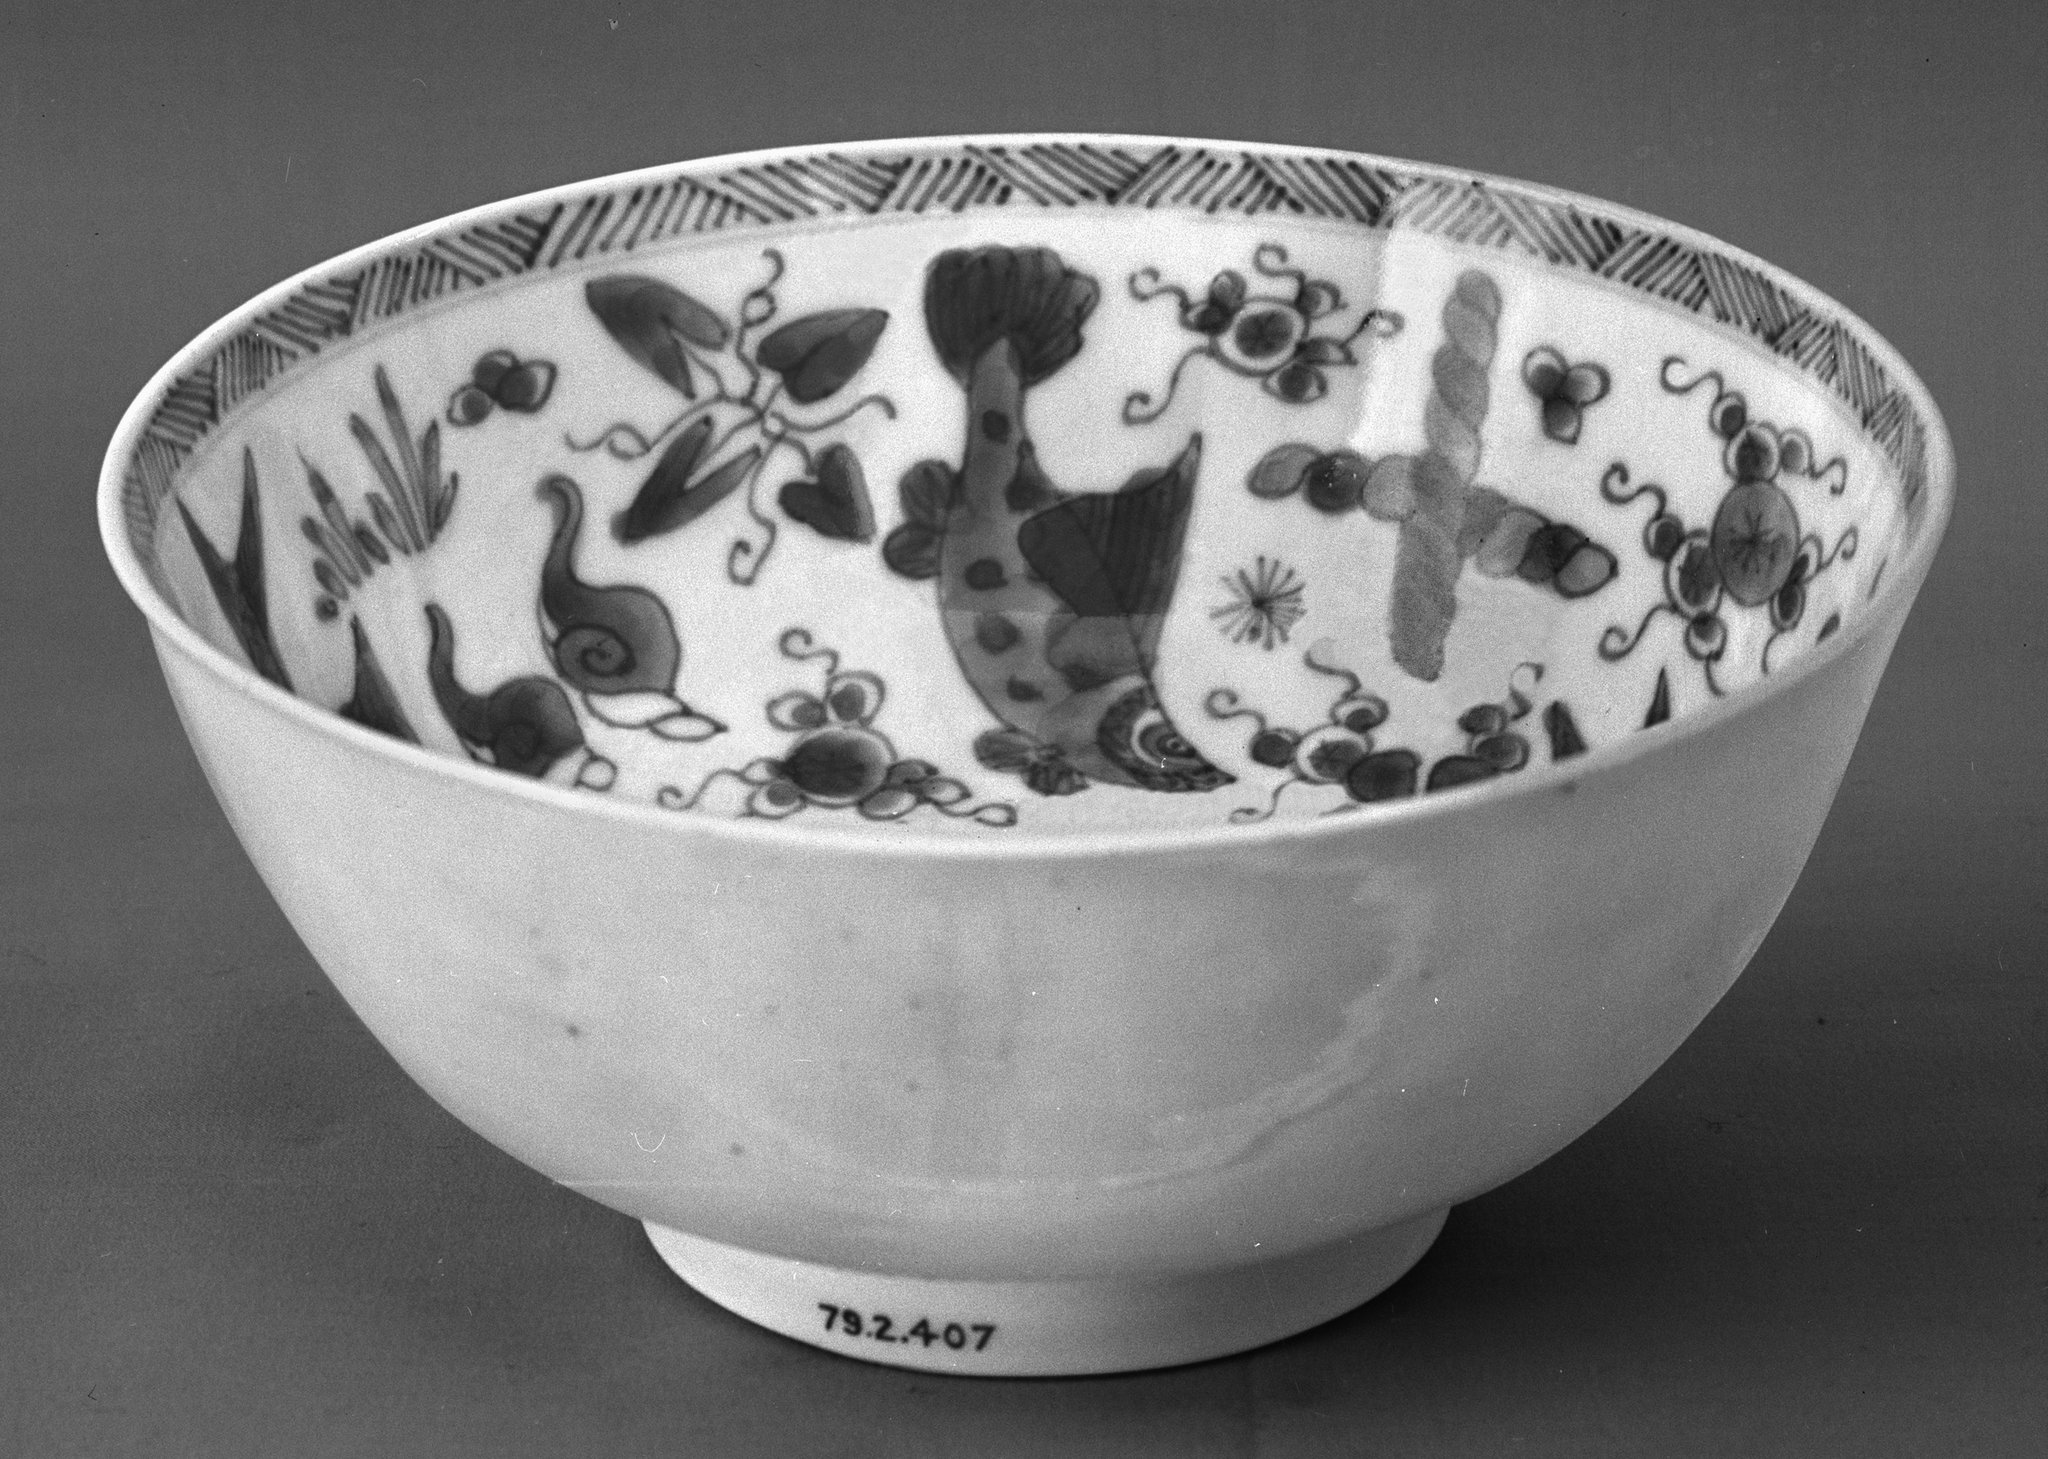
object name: bowl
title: Bowl with crab and fish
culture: chinese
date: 1701-1800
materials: glaze, porcelain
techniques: painting, underglaze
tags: crabs,fish